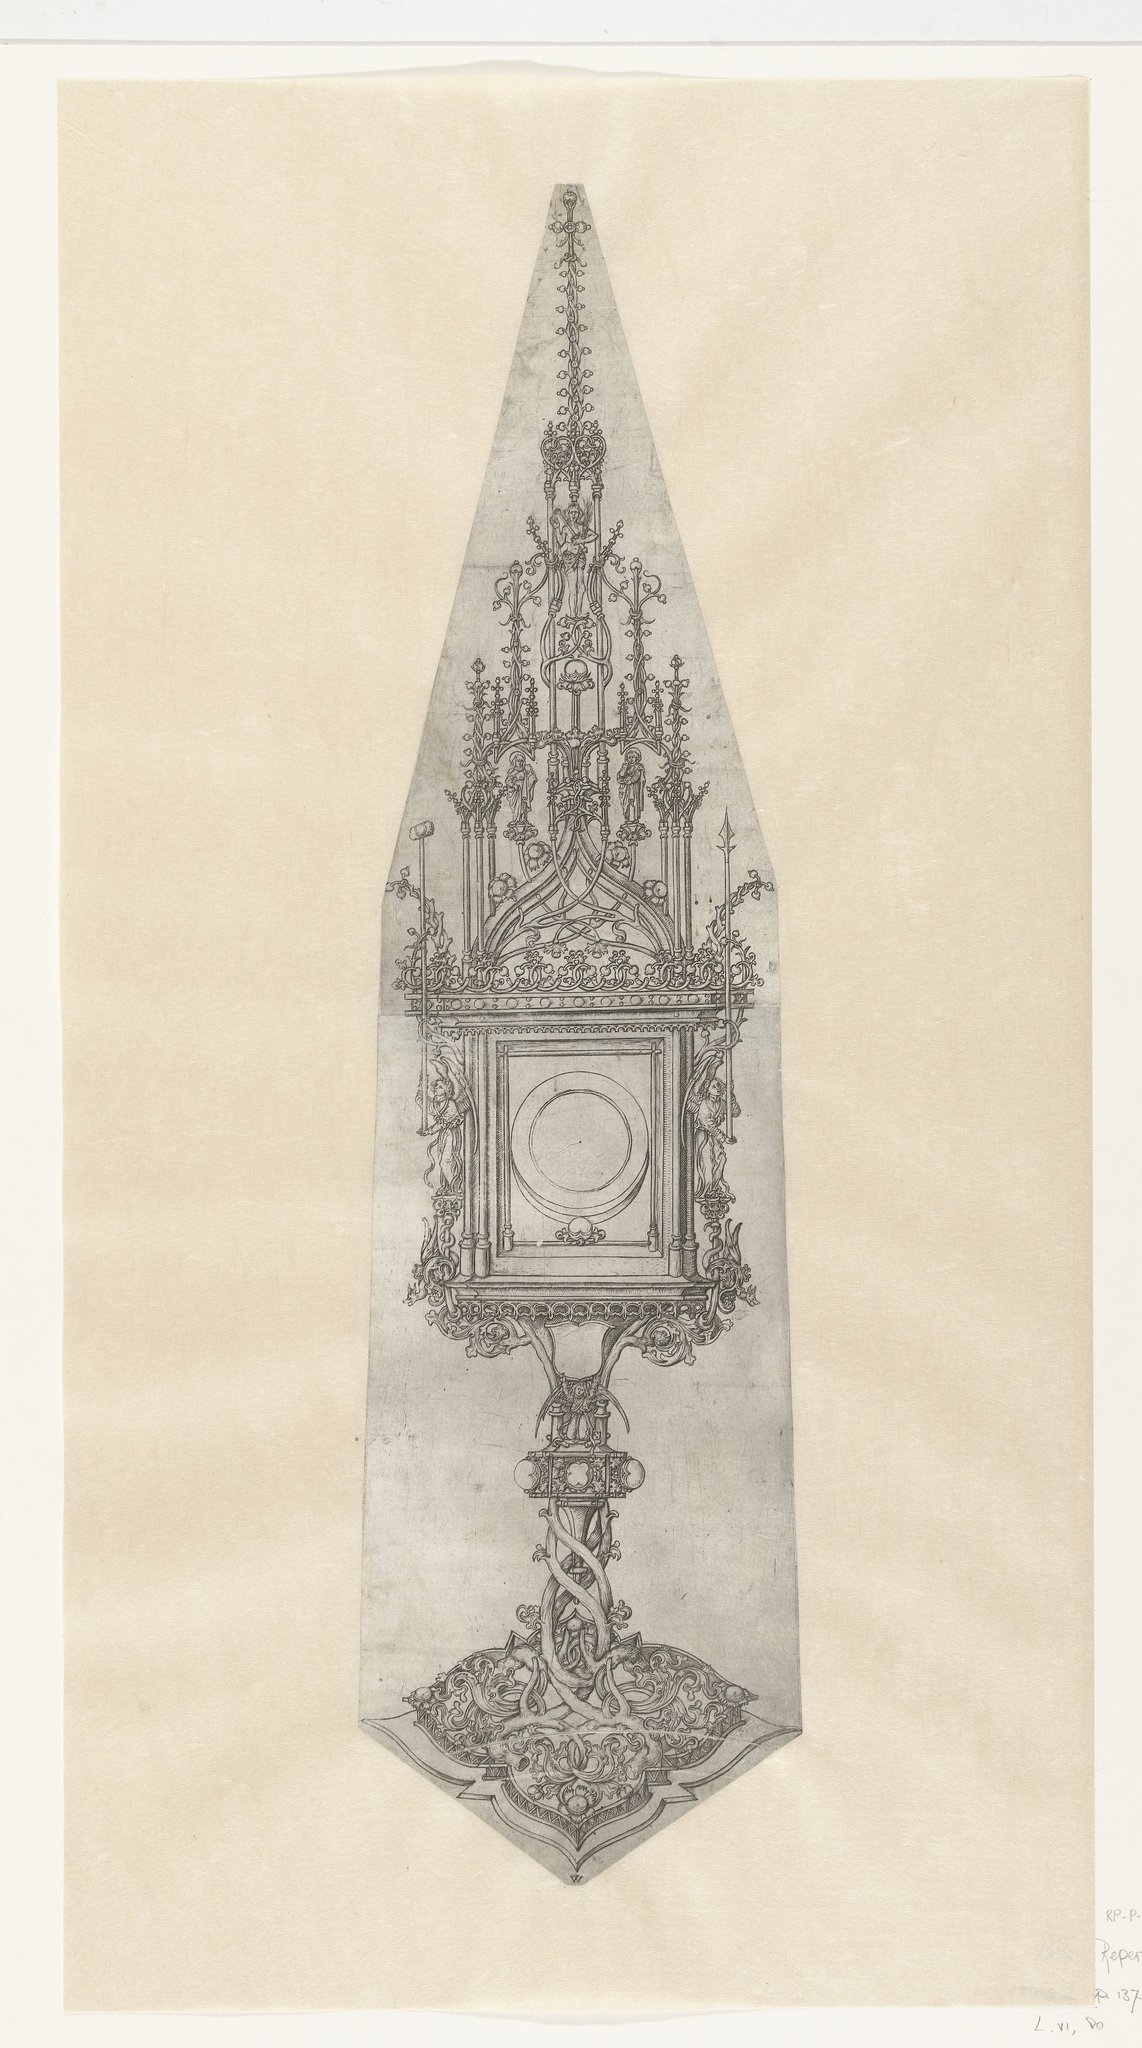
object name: print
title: Design for a Gothic Monstrance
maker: wenzel von olmütz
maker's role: jeweler, print maker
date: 1481-1497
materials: paper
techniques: engraving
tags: ostensorium, monstrance, single instruments of the passion, crucified christ with mary and john on either side of the cross; holy rood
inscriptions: collector's mark: Lugt 240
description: This design served as inspiration and was not meant to be literally reproduced. The base and trunk of intertwined branches and leaves, for example, would be very difficult to execute and never form a stable whole. Certain decorative elements recur frequently in art from Wenzel von Olmütz’s time. In addition to the foliate motifs, note the angels here and elsewhere in the gallery.